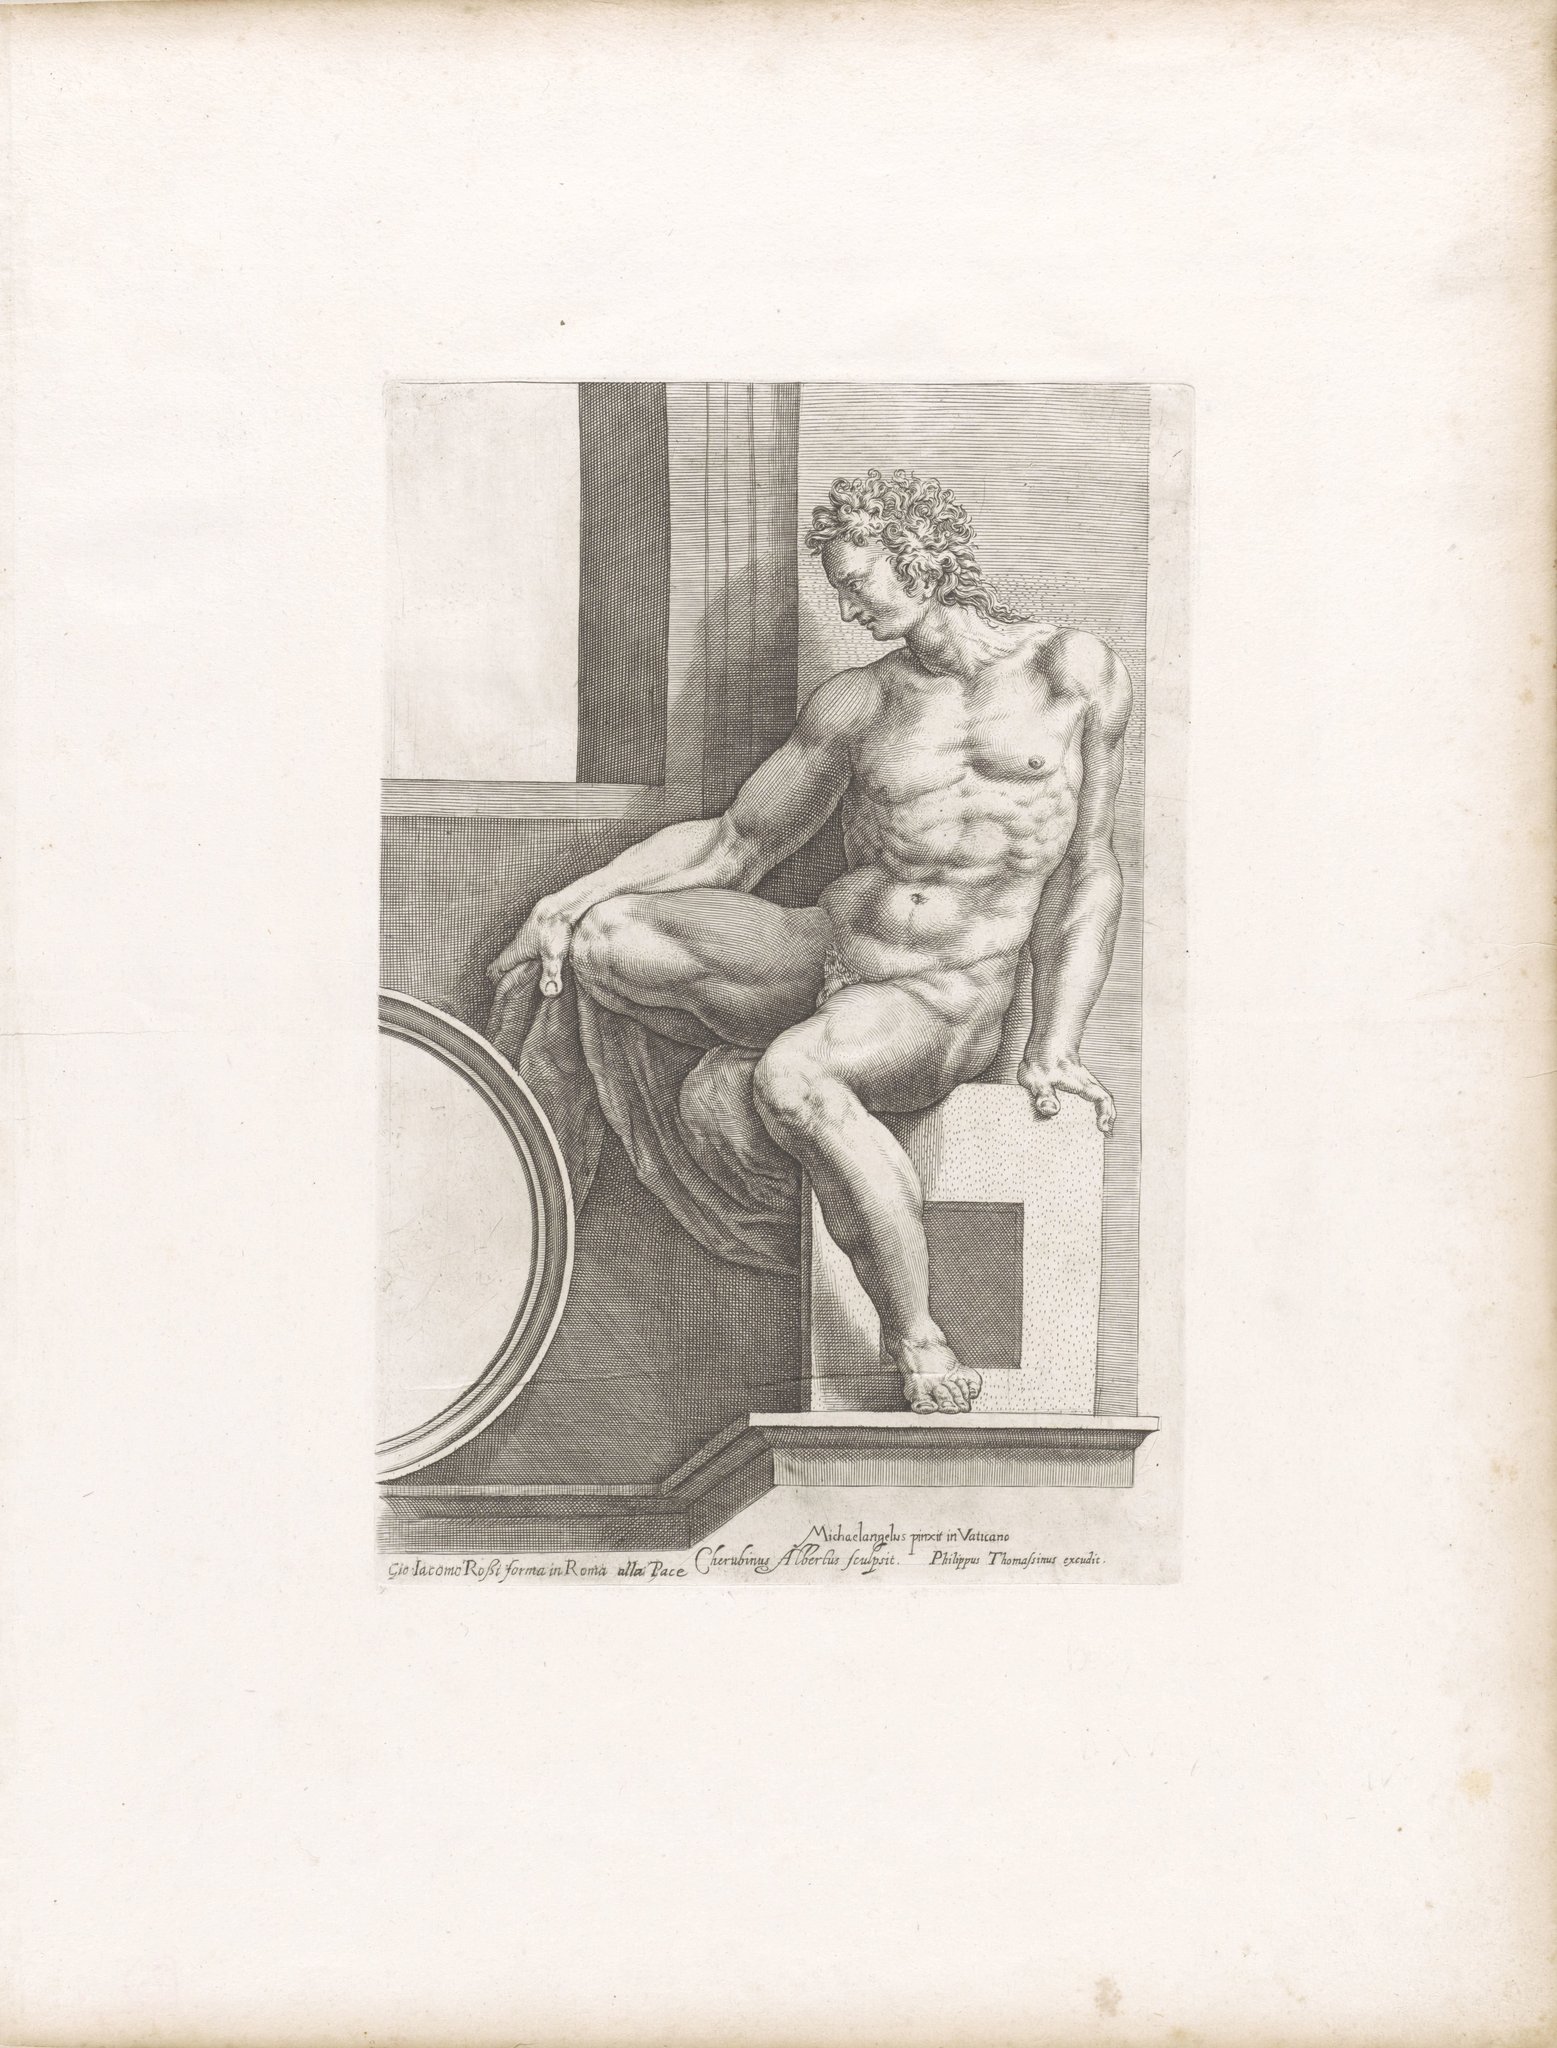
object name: print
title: Michelangelo's ignudi uit de Sixtijnse kapel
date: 1649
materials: paper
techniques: engraving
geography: italy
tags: the (nude) human figure; 'corpo humano' (ripa)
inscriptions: collector's mark: Lugt 2228, collector's mark: Lugt 2760, collector's mark: Lugt 3616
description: Prent uit een reeks van vier prenten naar Michelangelo's ignudi uit de Sixtijnse Kapel (Bartsch 147-150).